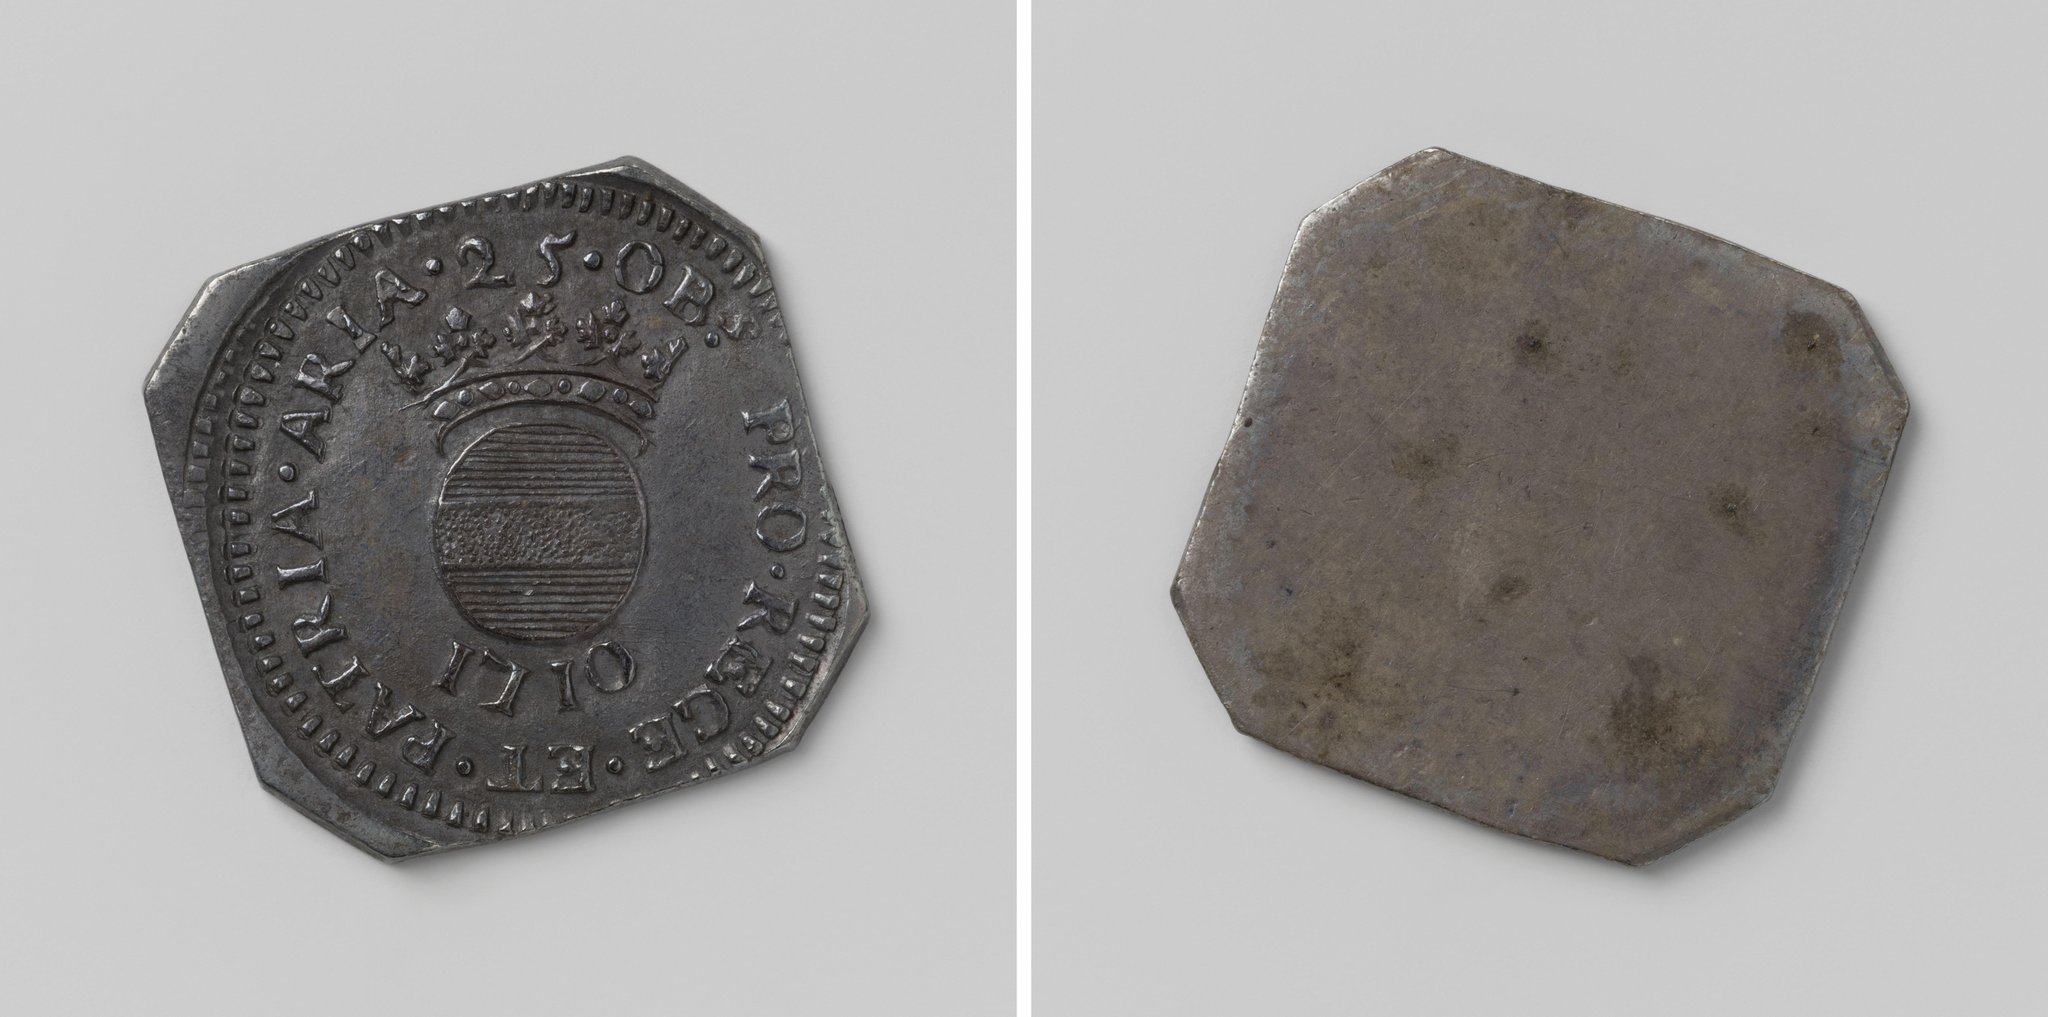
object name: coin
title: Vijfentwintig stuiver, noodmunt uit Aire, door de bondgenoten ingenomen, geslagen op last van markgraaf Guebriant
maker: Anonymous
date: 1709-1710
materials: silver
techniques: striking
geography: aire-sur-la-lys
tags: markgraaf guebriant, aire-sur-la-lys, inname van aire (1710)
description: Eenzijdige, vierkante zilveren noodmunt met afgeschuinde hoeken. Voorzijde: gekroond wapenschild tussen jaartal binnen omschrift en parelrand. Keerzijde: blanco.